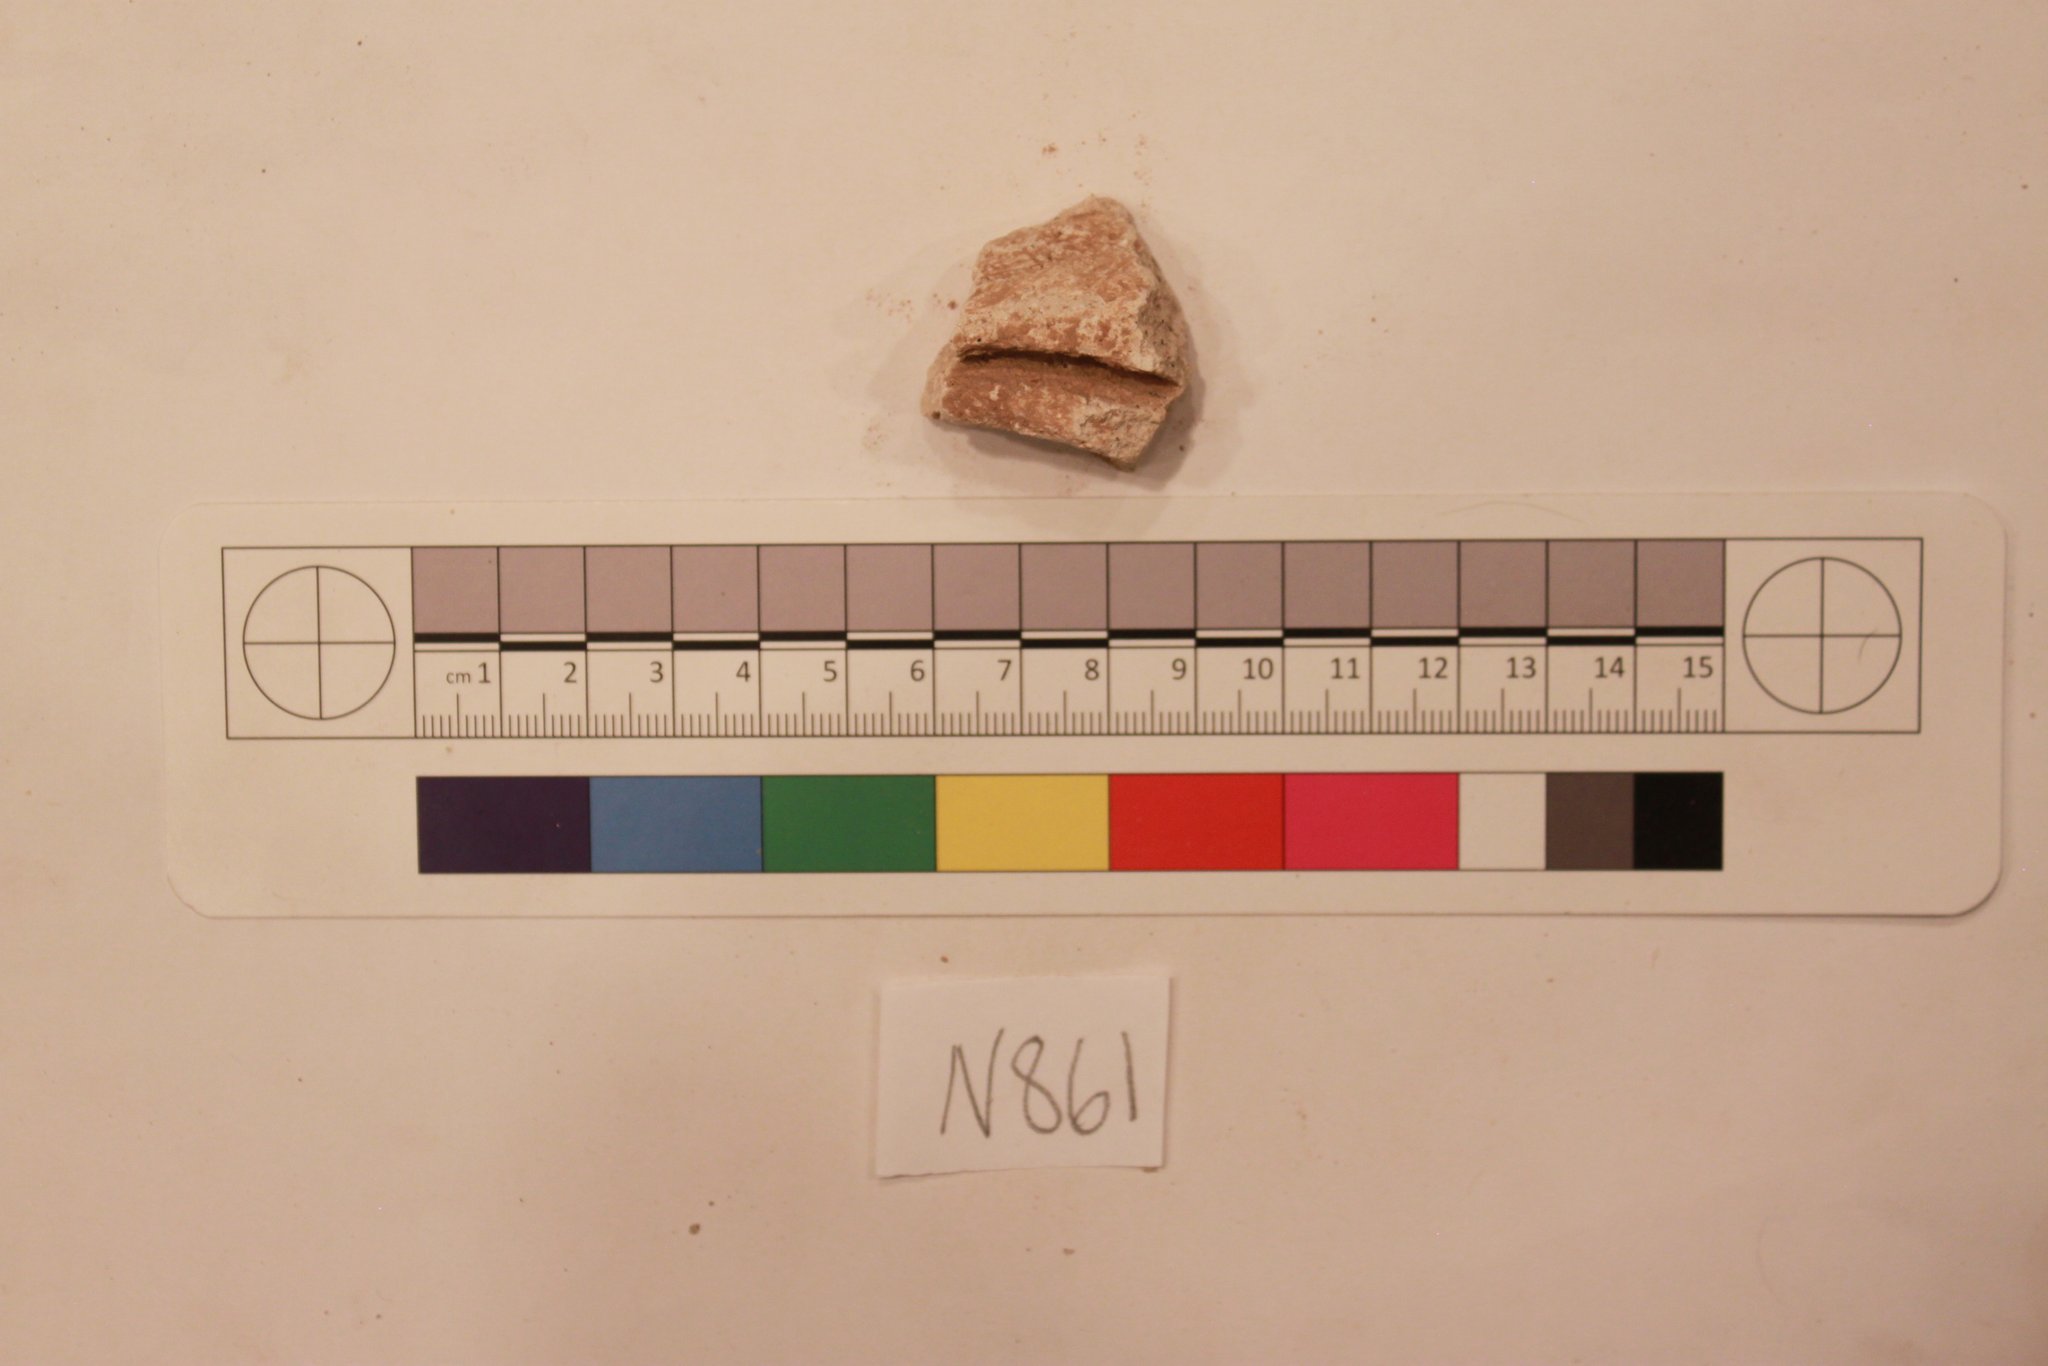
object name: fragment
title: Stucco Fragment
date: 701-1200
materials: plaster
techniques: carving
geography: iran